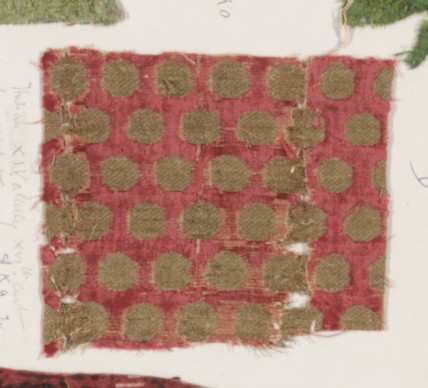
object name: fragment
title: Fragments of velvet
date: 1267-1400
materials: metal thread, silk